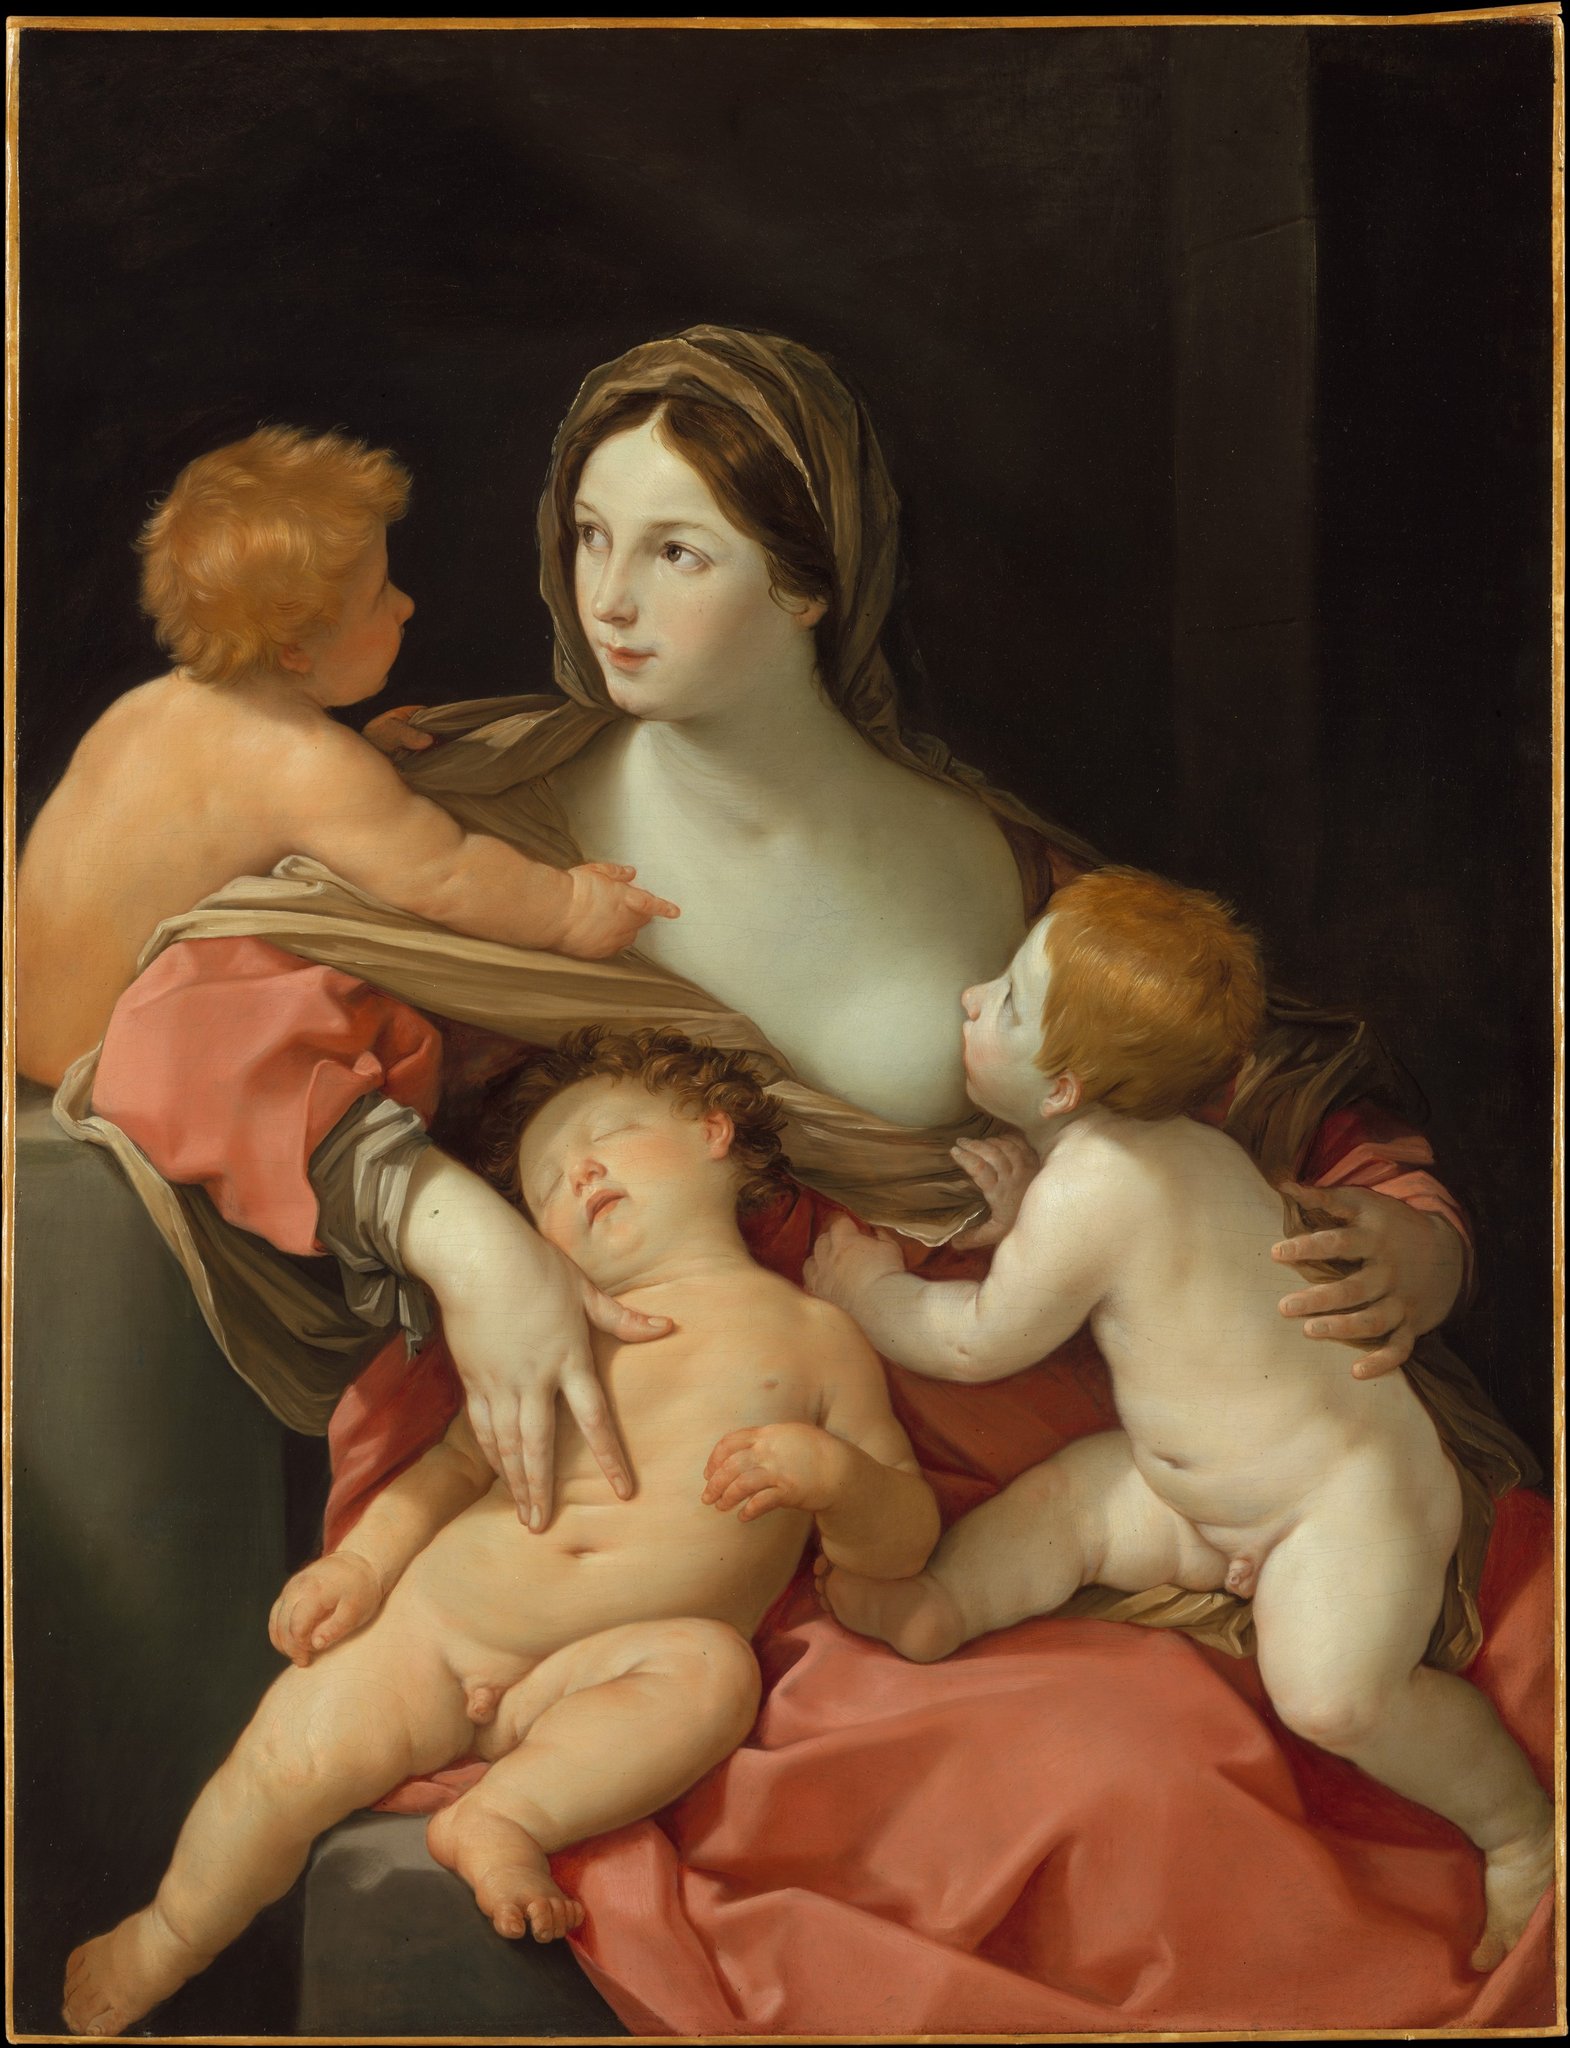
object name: painting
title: Charity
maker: guido reni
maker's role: artist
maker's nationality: italian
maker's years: 1575-1642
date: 1630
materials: canvas, oil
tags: children,women,allegory,nursing